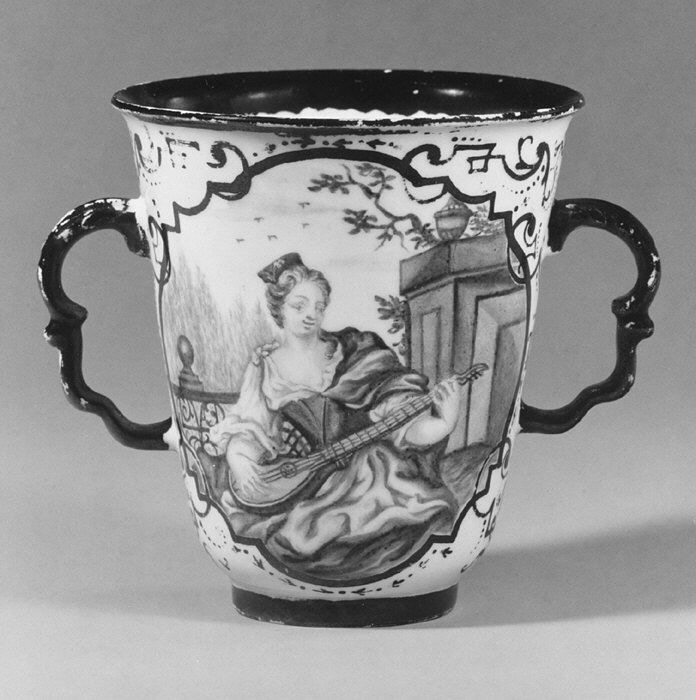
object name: chocolate cup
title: Chocolate cup (part of a service)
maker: meissen manufactory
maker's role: manufactory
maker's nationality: german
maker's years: 1710-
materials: hard paste porcelain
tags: musical instruments,women